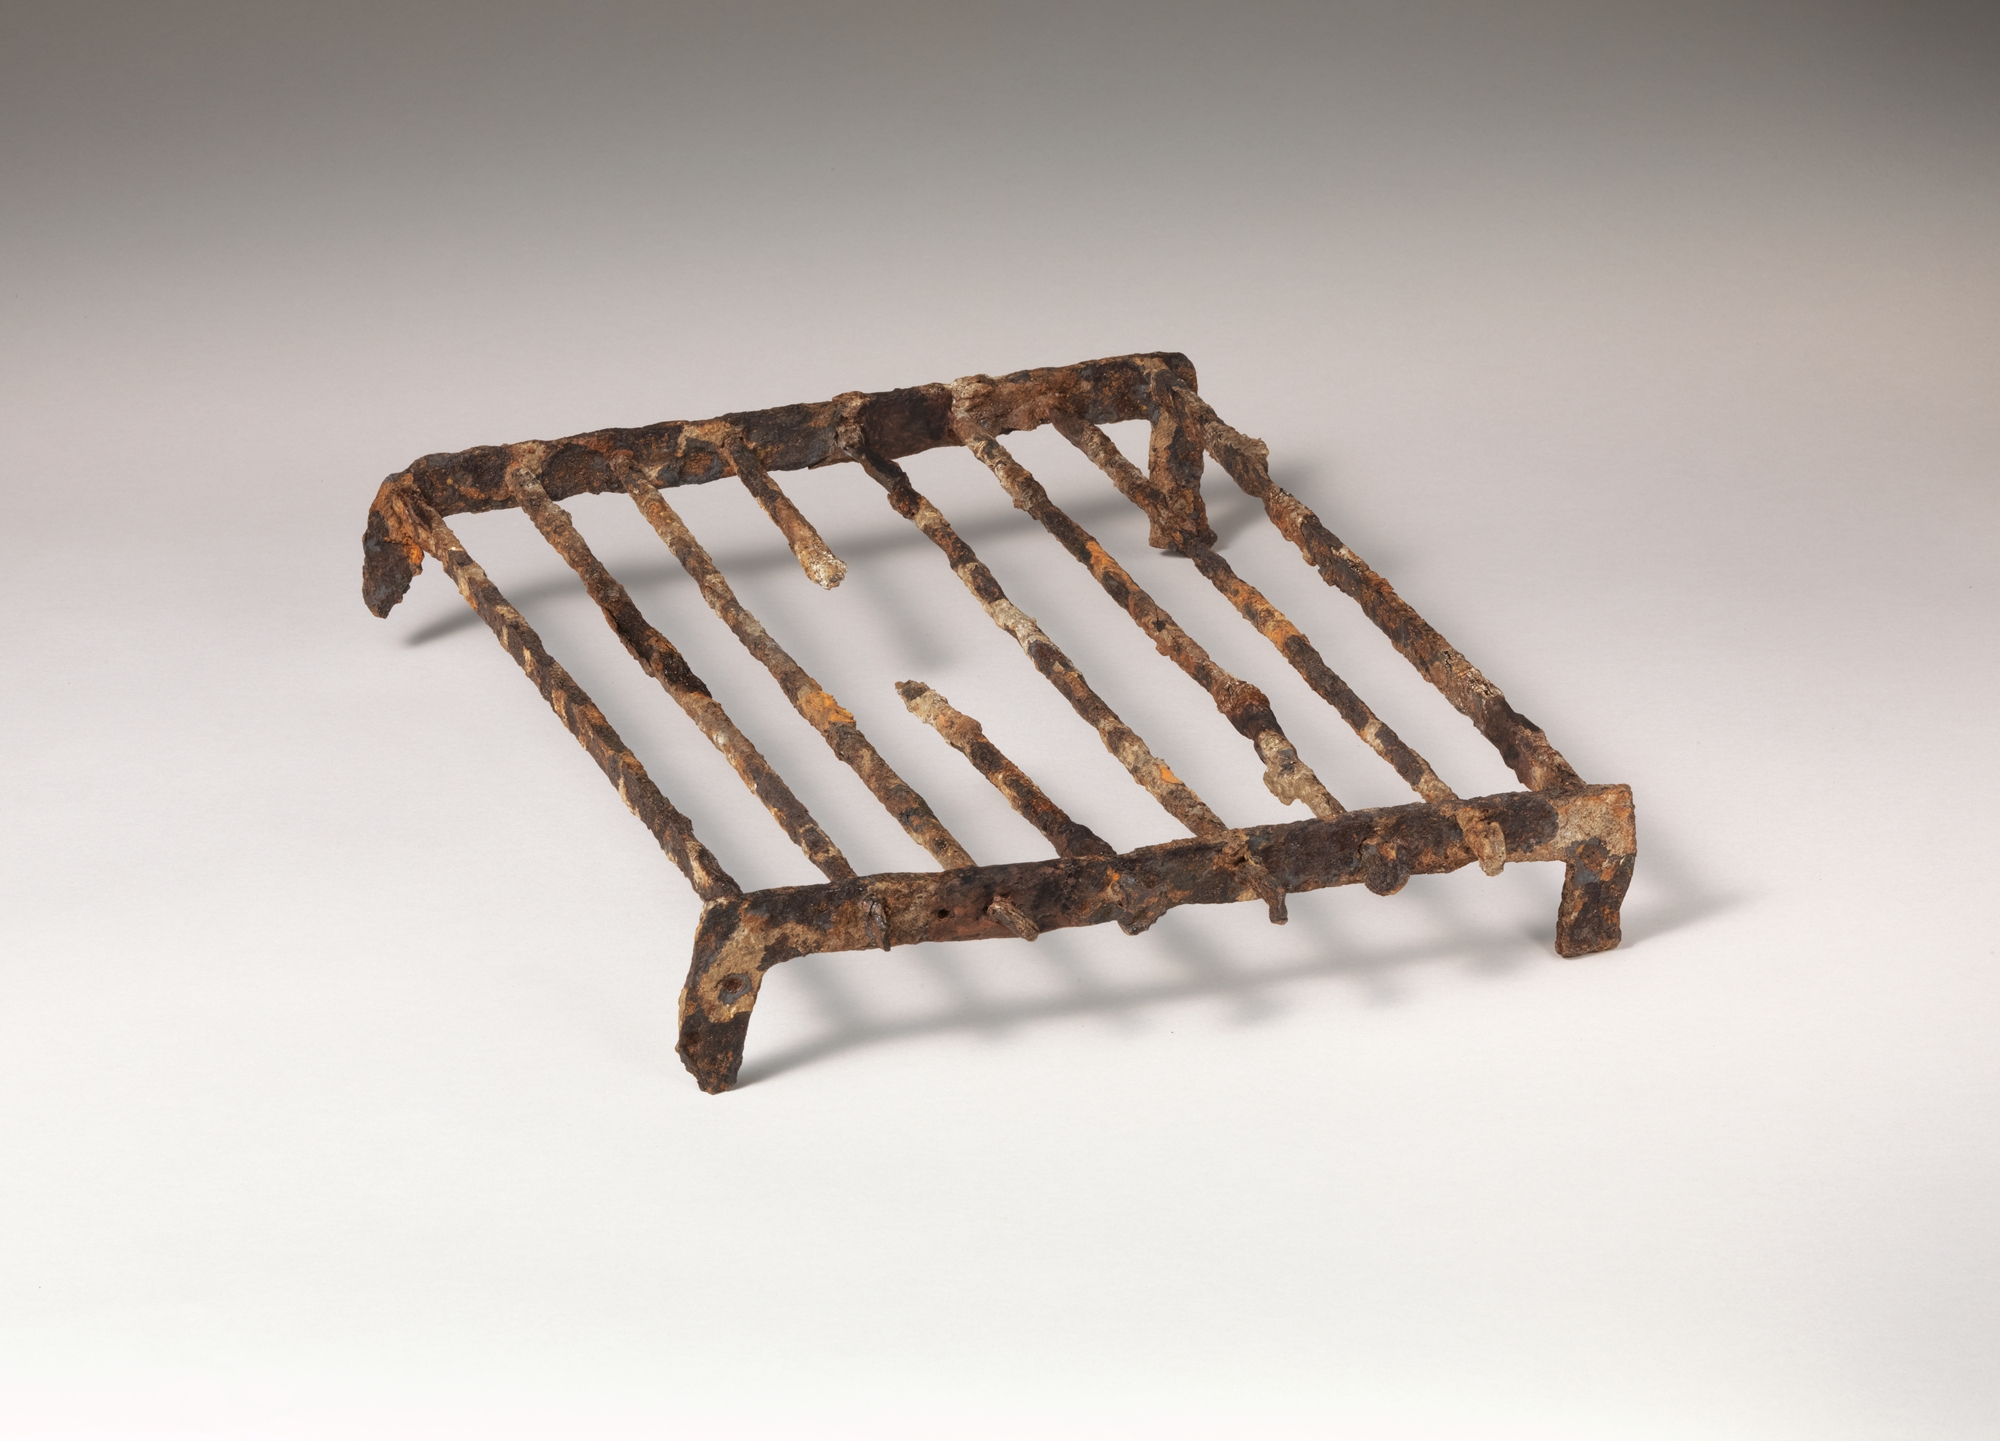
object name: fire grate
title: Iron fire-grate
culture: etruscan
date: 550 BCE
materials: iron